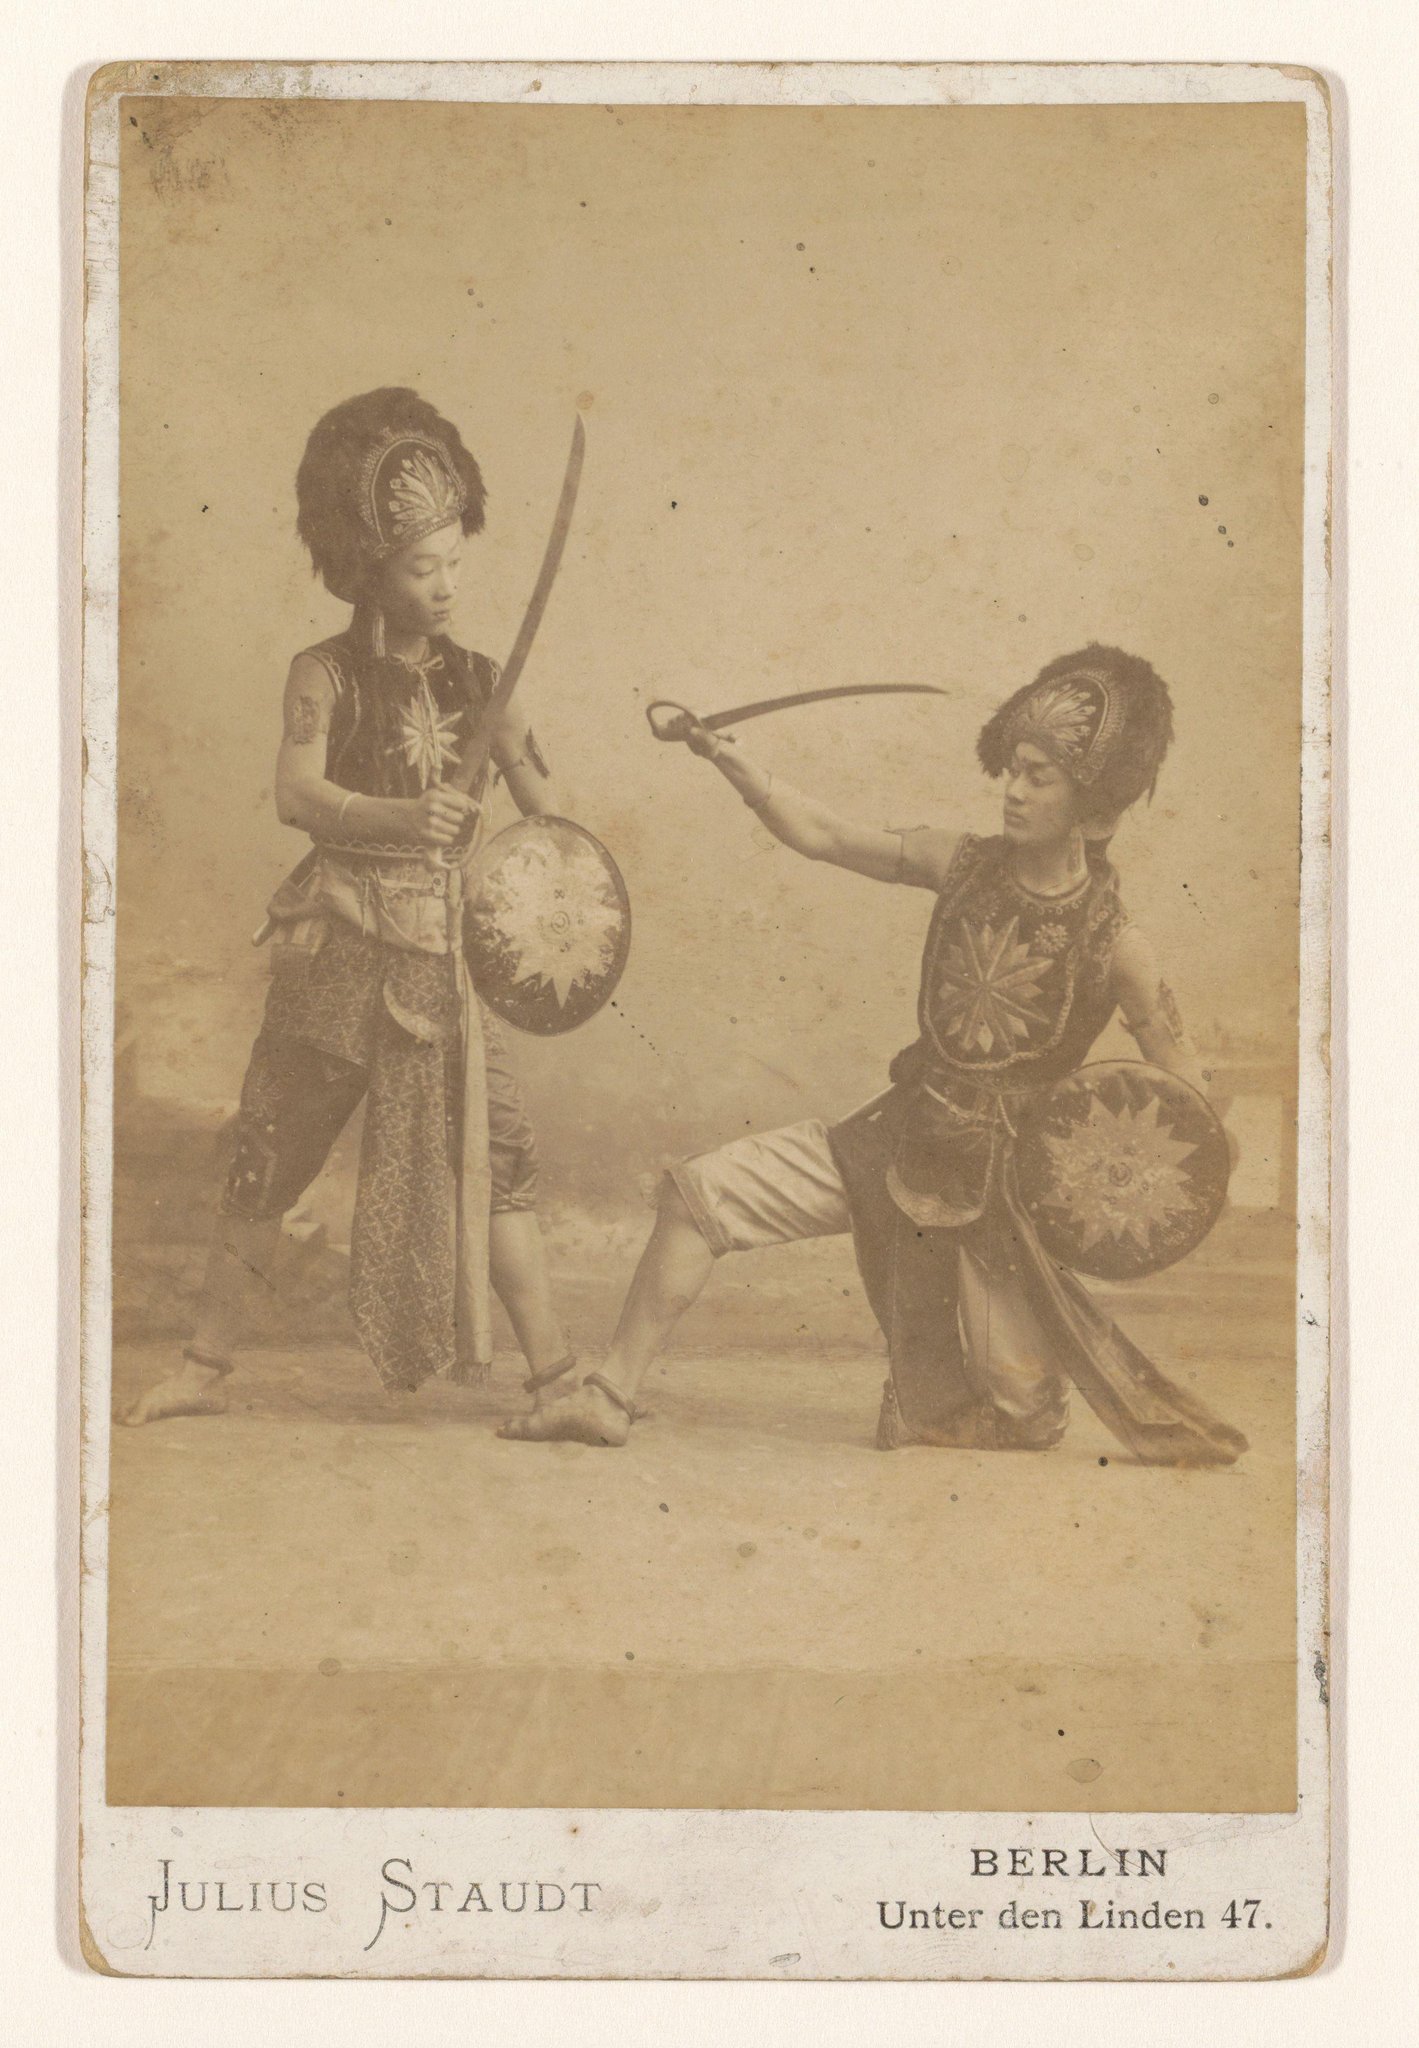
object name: cabinet photograph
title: Studioportret van twee onbekende Aziatische krijgers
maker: julius staudt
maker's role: fotograaf, fotostudio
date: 1896-1910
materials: cardboard, paper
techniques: albumen print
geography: berlin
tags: hacking and thrusting weapons: sword, anonymous historical person portrayed, knight, berlin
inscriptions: inscription: ‘Julius Staudt/ Berlin/ Unter den Linden 47.’